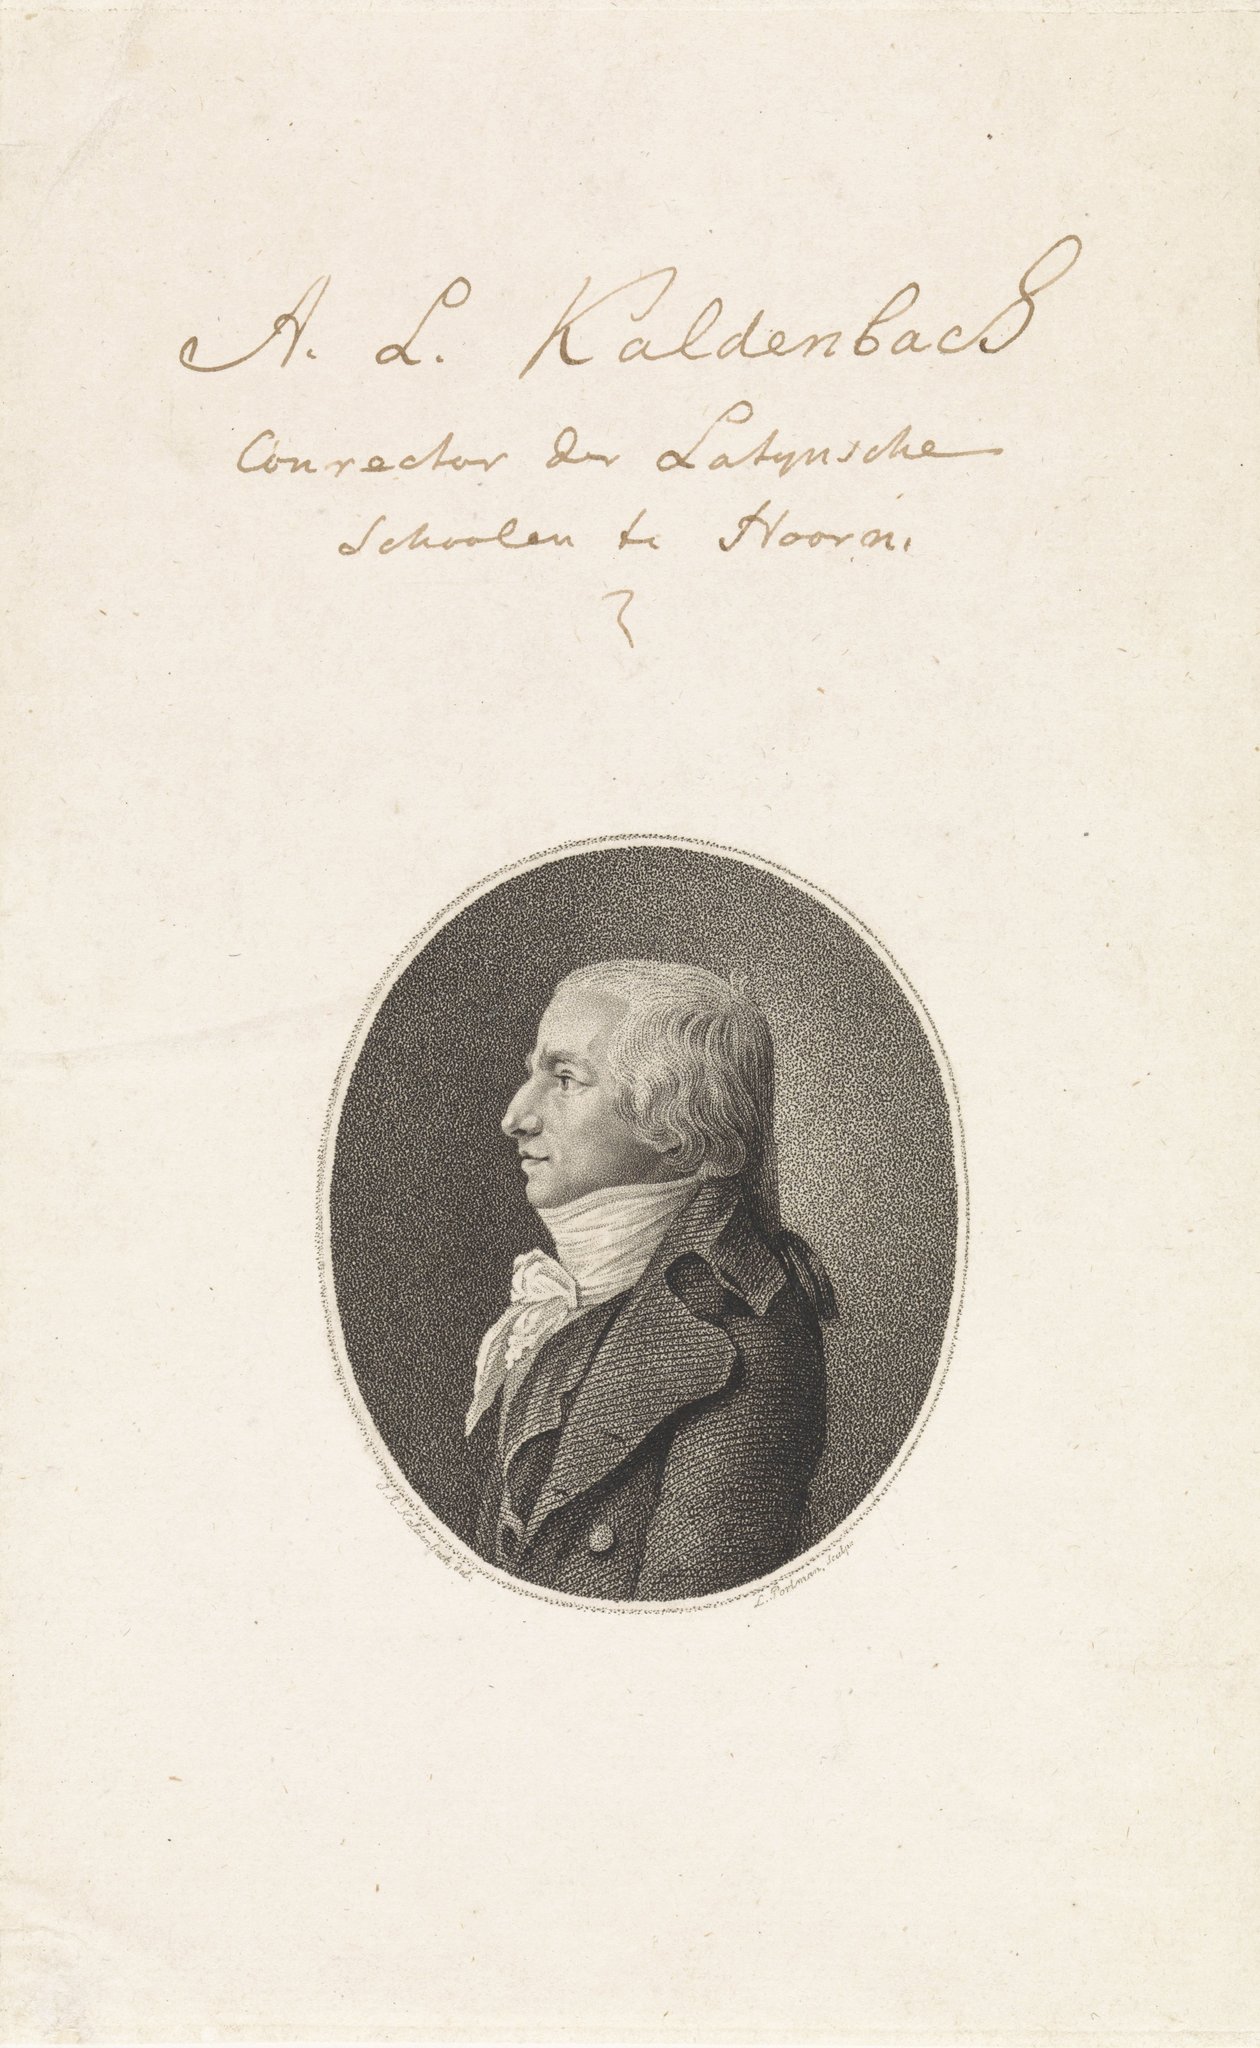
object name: print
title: Portret van conrector Adam Leonard Kaldenbach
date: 1801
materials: paper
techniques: stippled etching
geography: amsterdam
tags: zutphen (stad), dichter, rector, adam leonard kaldenbach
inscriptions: collector's mark: Lugt 2228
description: Prent ook gebruikt als titelpagina voor: Broes, Petrus. De peinzende kristen, in eene verzameling van godsdienstige, bespiegelingen gevolgd. Amsterdam: J.B. Elwe, 1801.